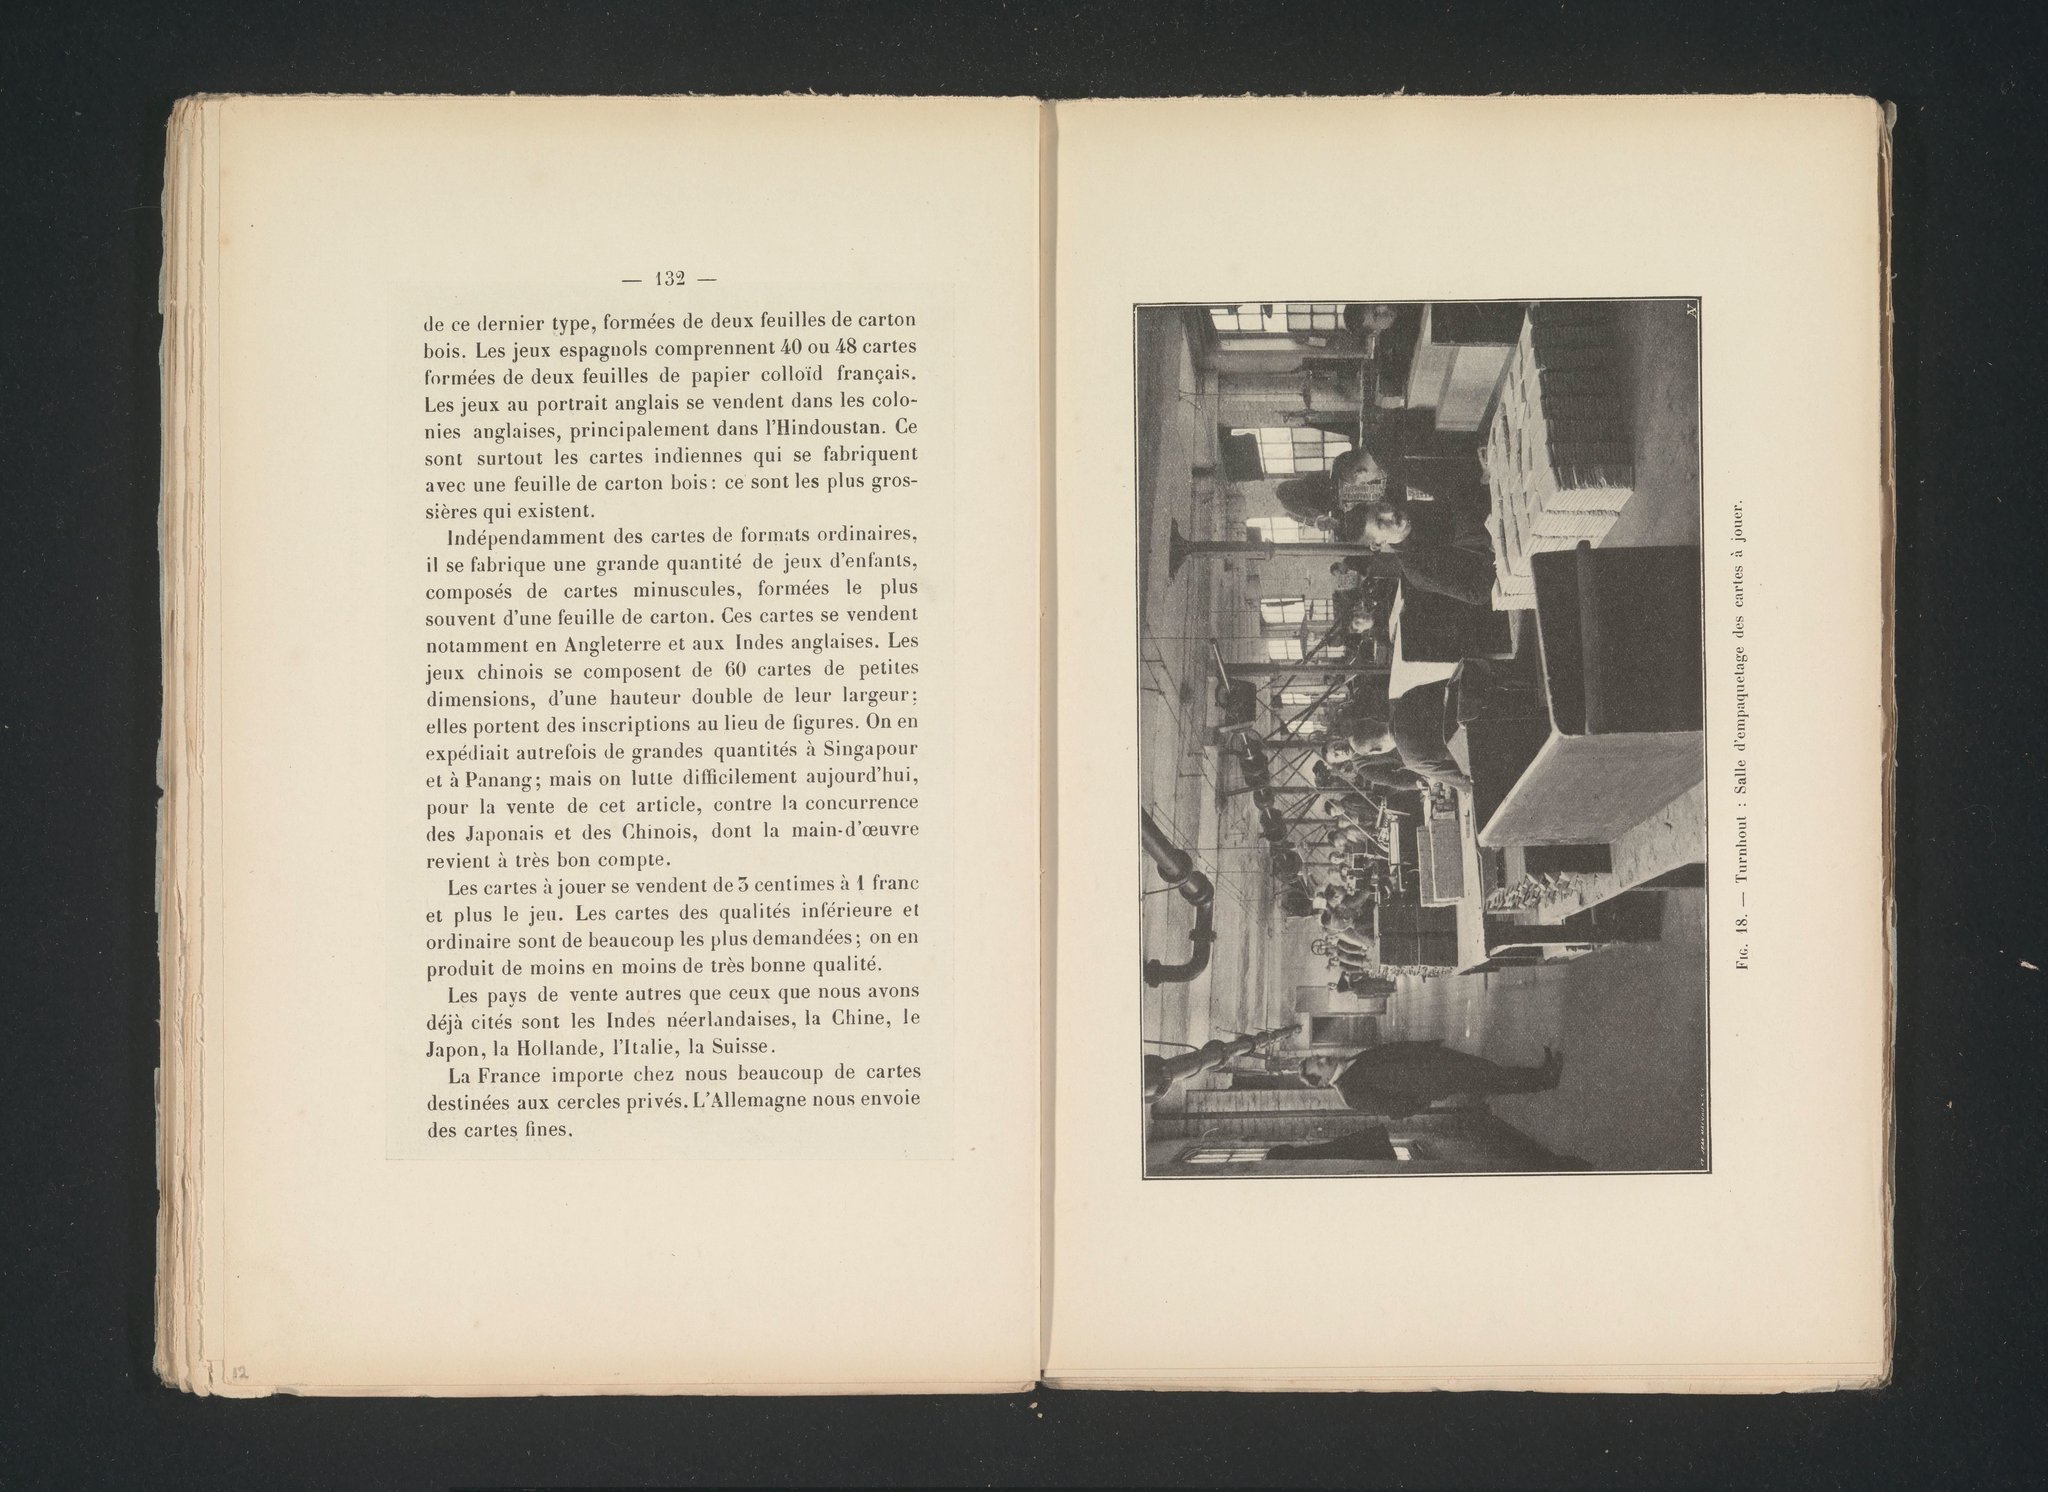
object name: page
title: Mannen pakken gedrukte speelkaarten in in een drukkerij in Turnhout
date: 1901-1906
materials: paper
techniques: autotype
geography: turnhout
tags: adult man, printing, printing office, playing-cards, workshop-interior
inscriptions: inscription: ‘Fig. 18. - Turnhout: Salle d'empaquetage des cartes à jouer.’, monogram: ‘AN’